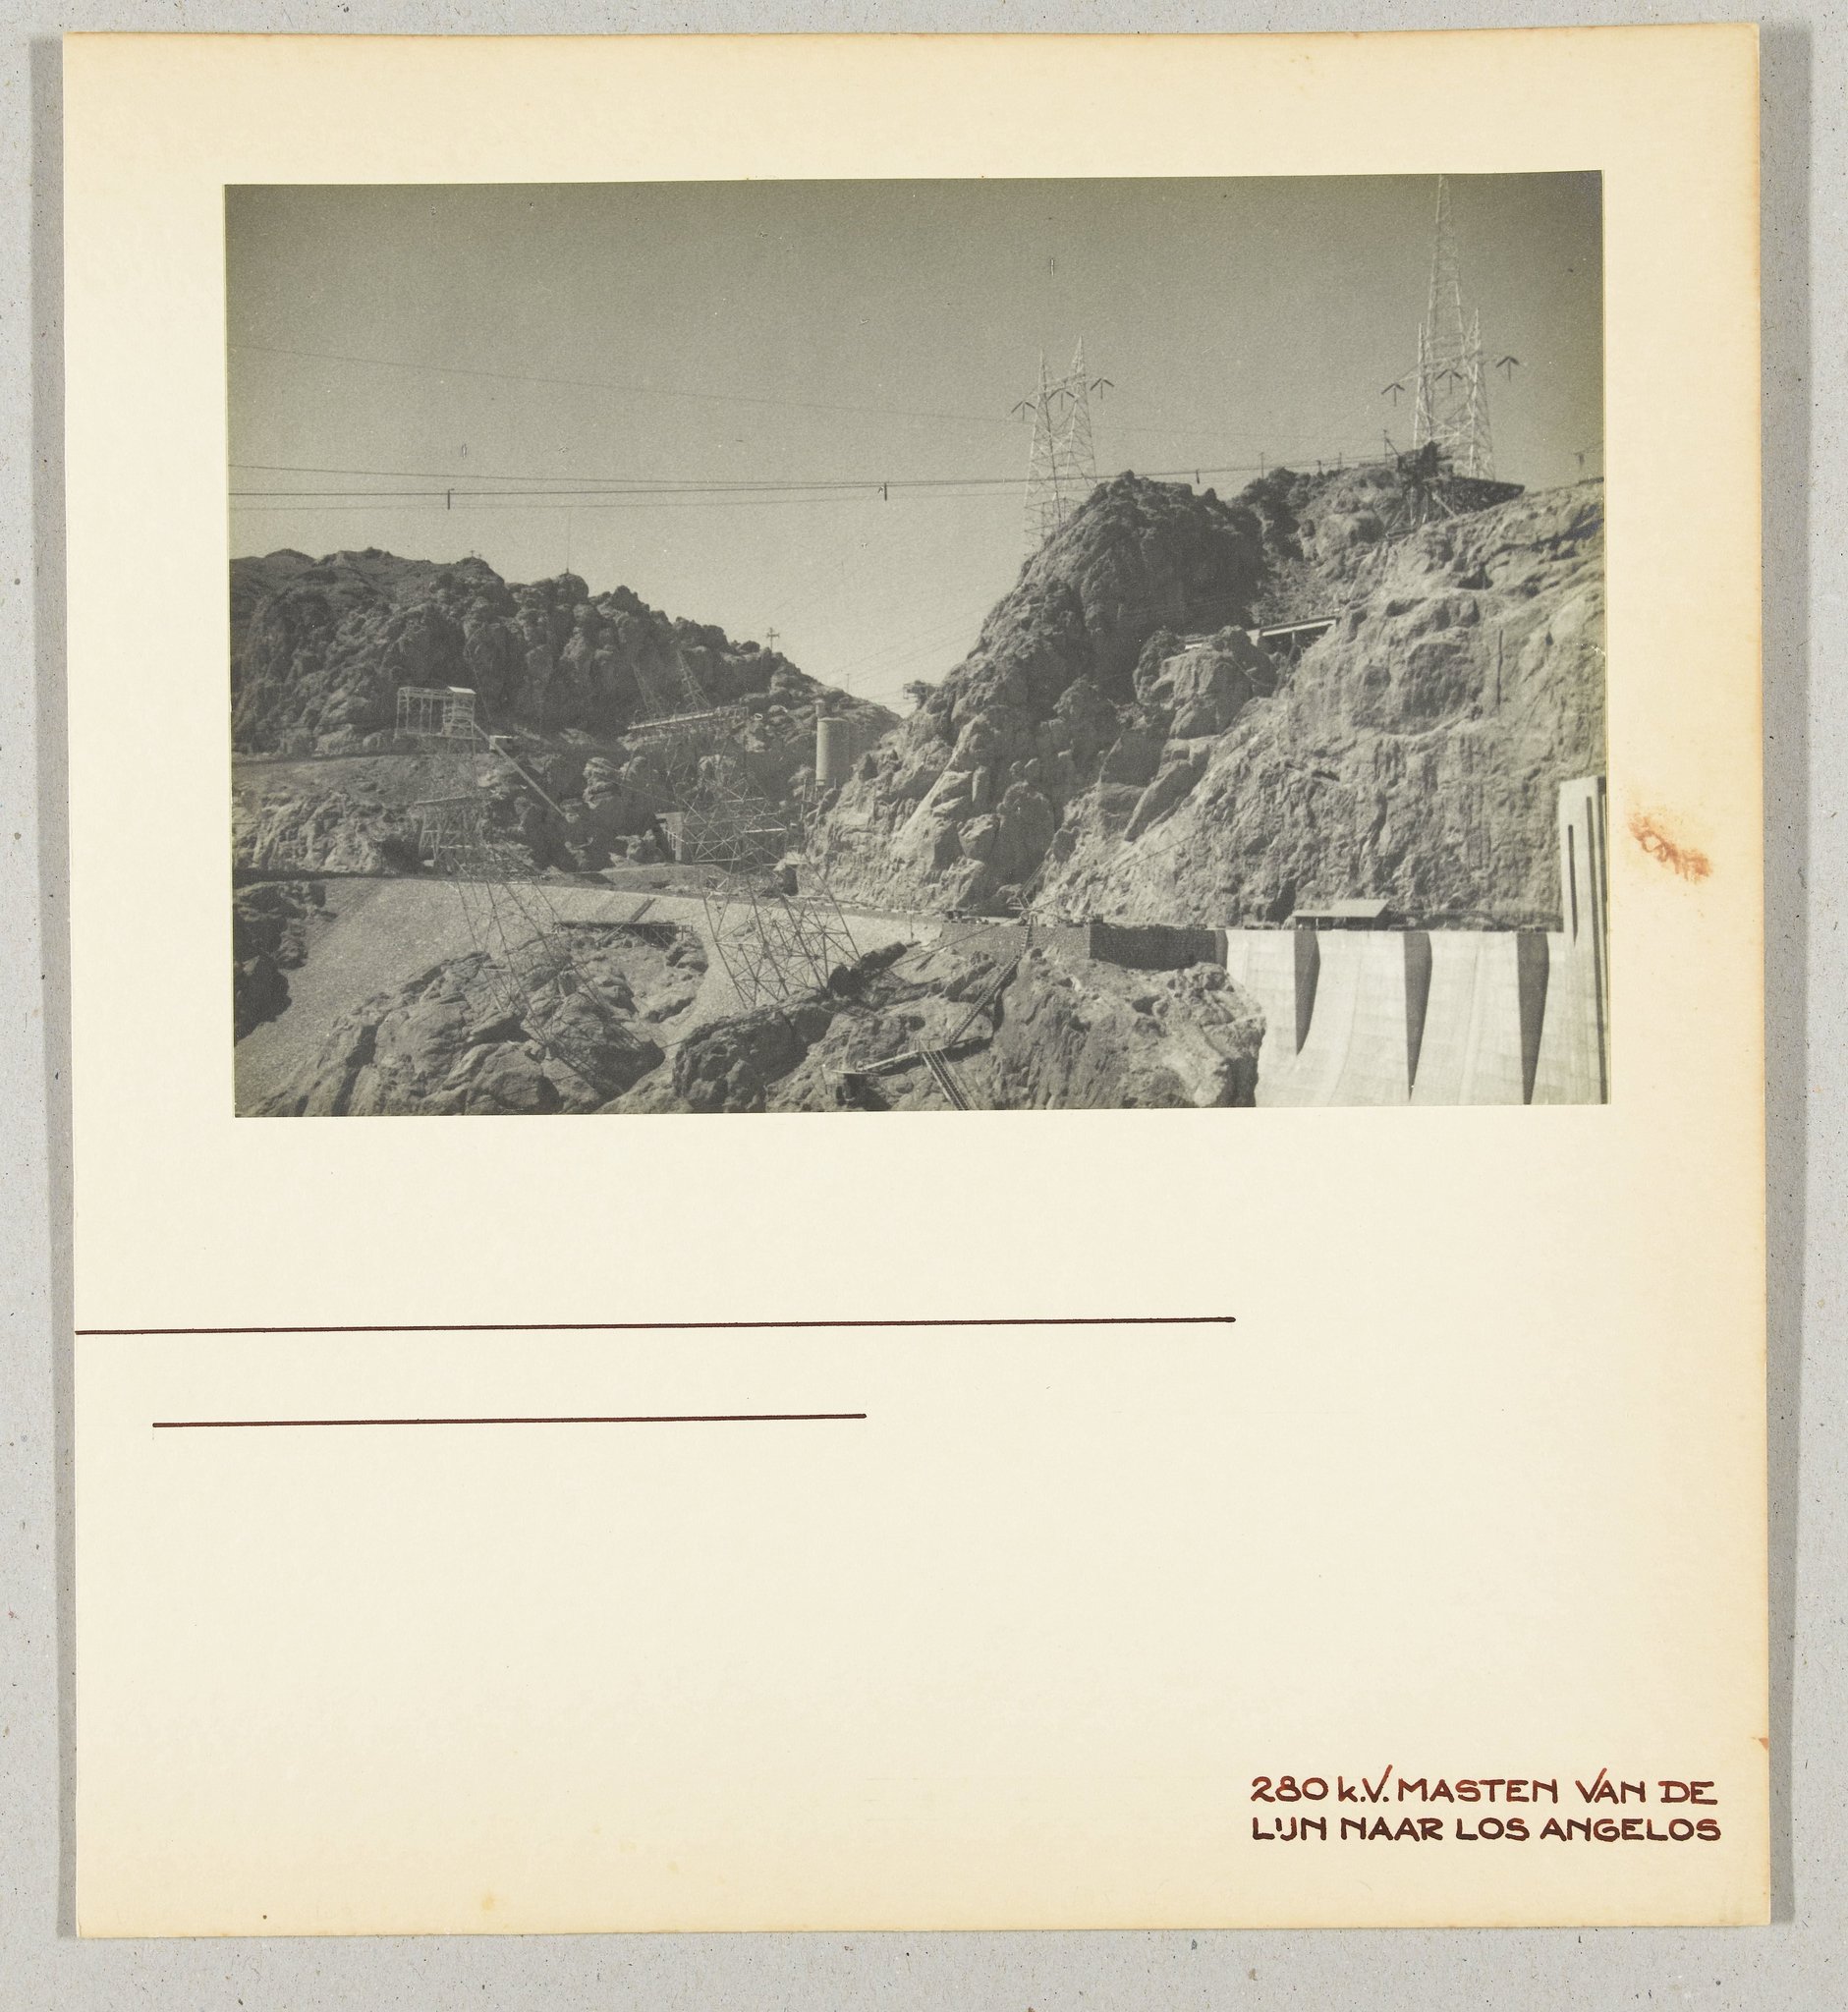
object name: photograph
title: 280 k.v masten van de lijn naar Los Angelos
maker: wouter cool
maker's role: engineer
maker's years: 1877-1947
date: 1936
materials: cardboard, paper, photographic support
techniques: gelatin silver print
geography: united states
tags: pylons, power lines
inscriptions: title: ‘280 k.V. MASTEN VAN DE / LIJN NAAR LOS ANGELOS’